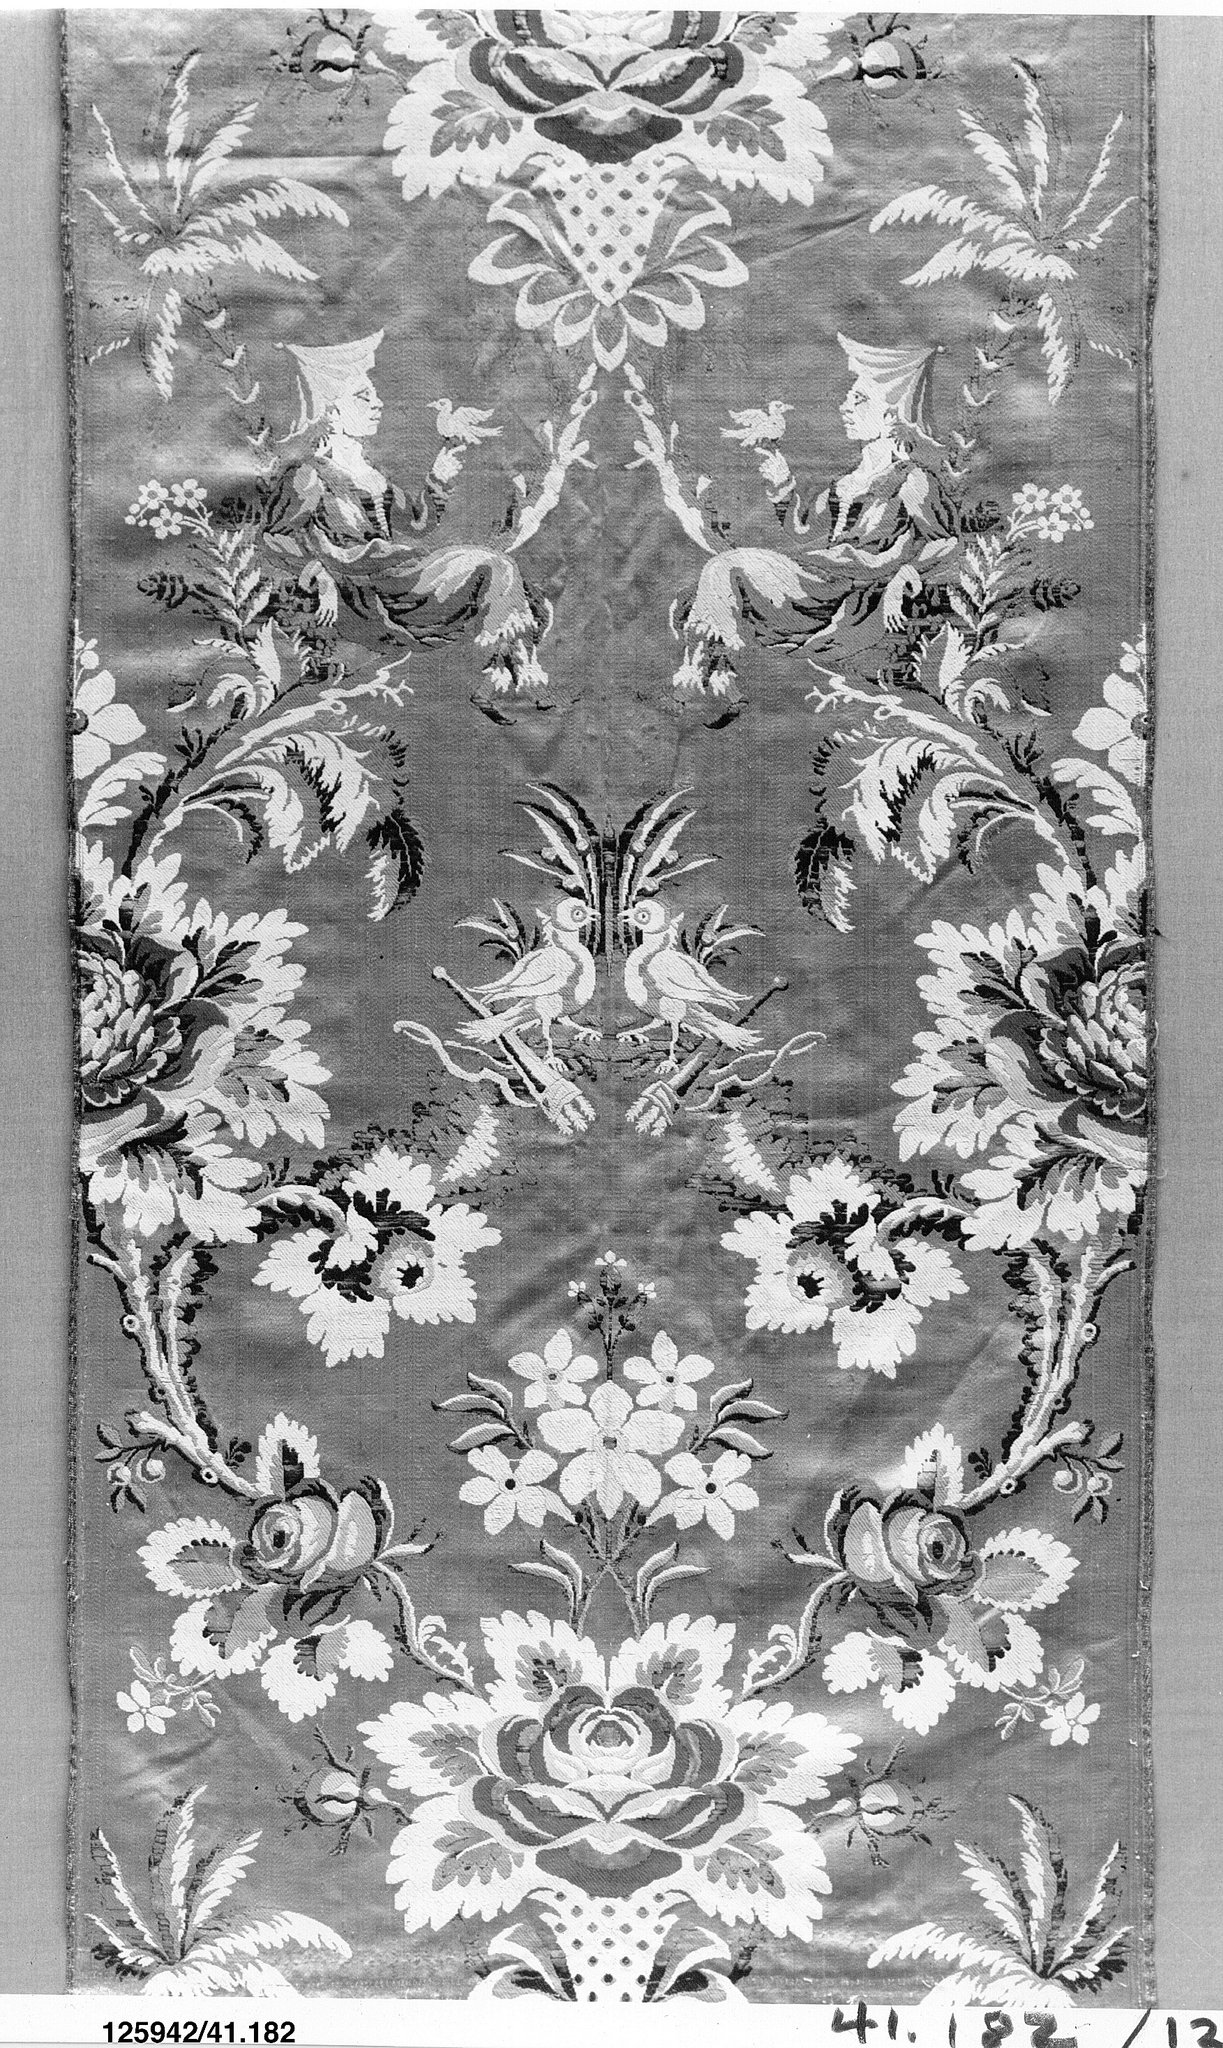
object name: piece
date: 1740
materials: silk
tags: birds,profiles,flowers,leaves